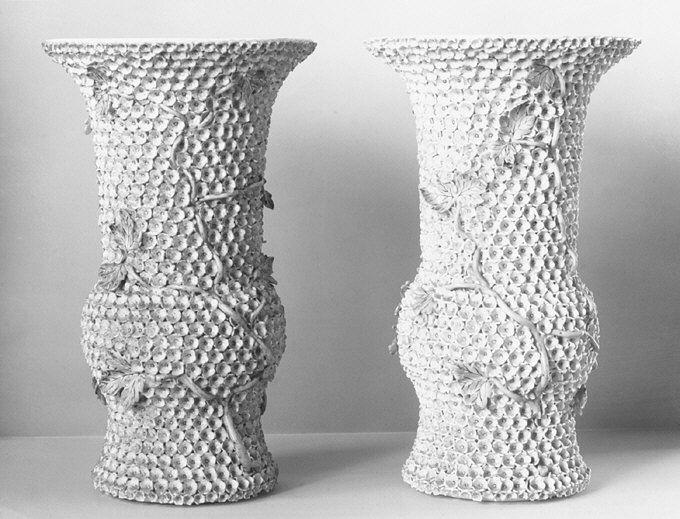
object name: vase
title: Pair of vases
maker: meissen manufactory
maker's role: manufactory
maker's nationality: german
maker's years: 1710-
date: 1750-1760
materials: porcelain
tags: flowers